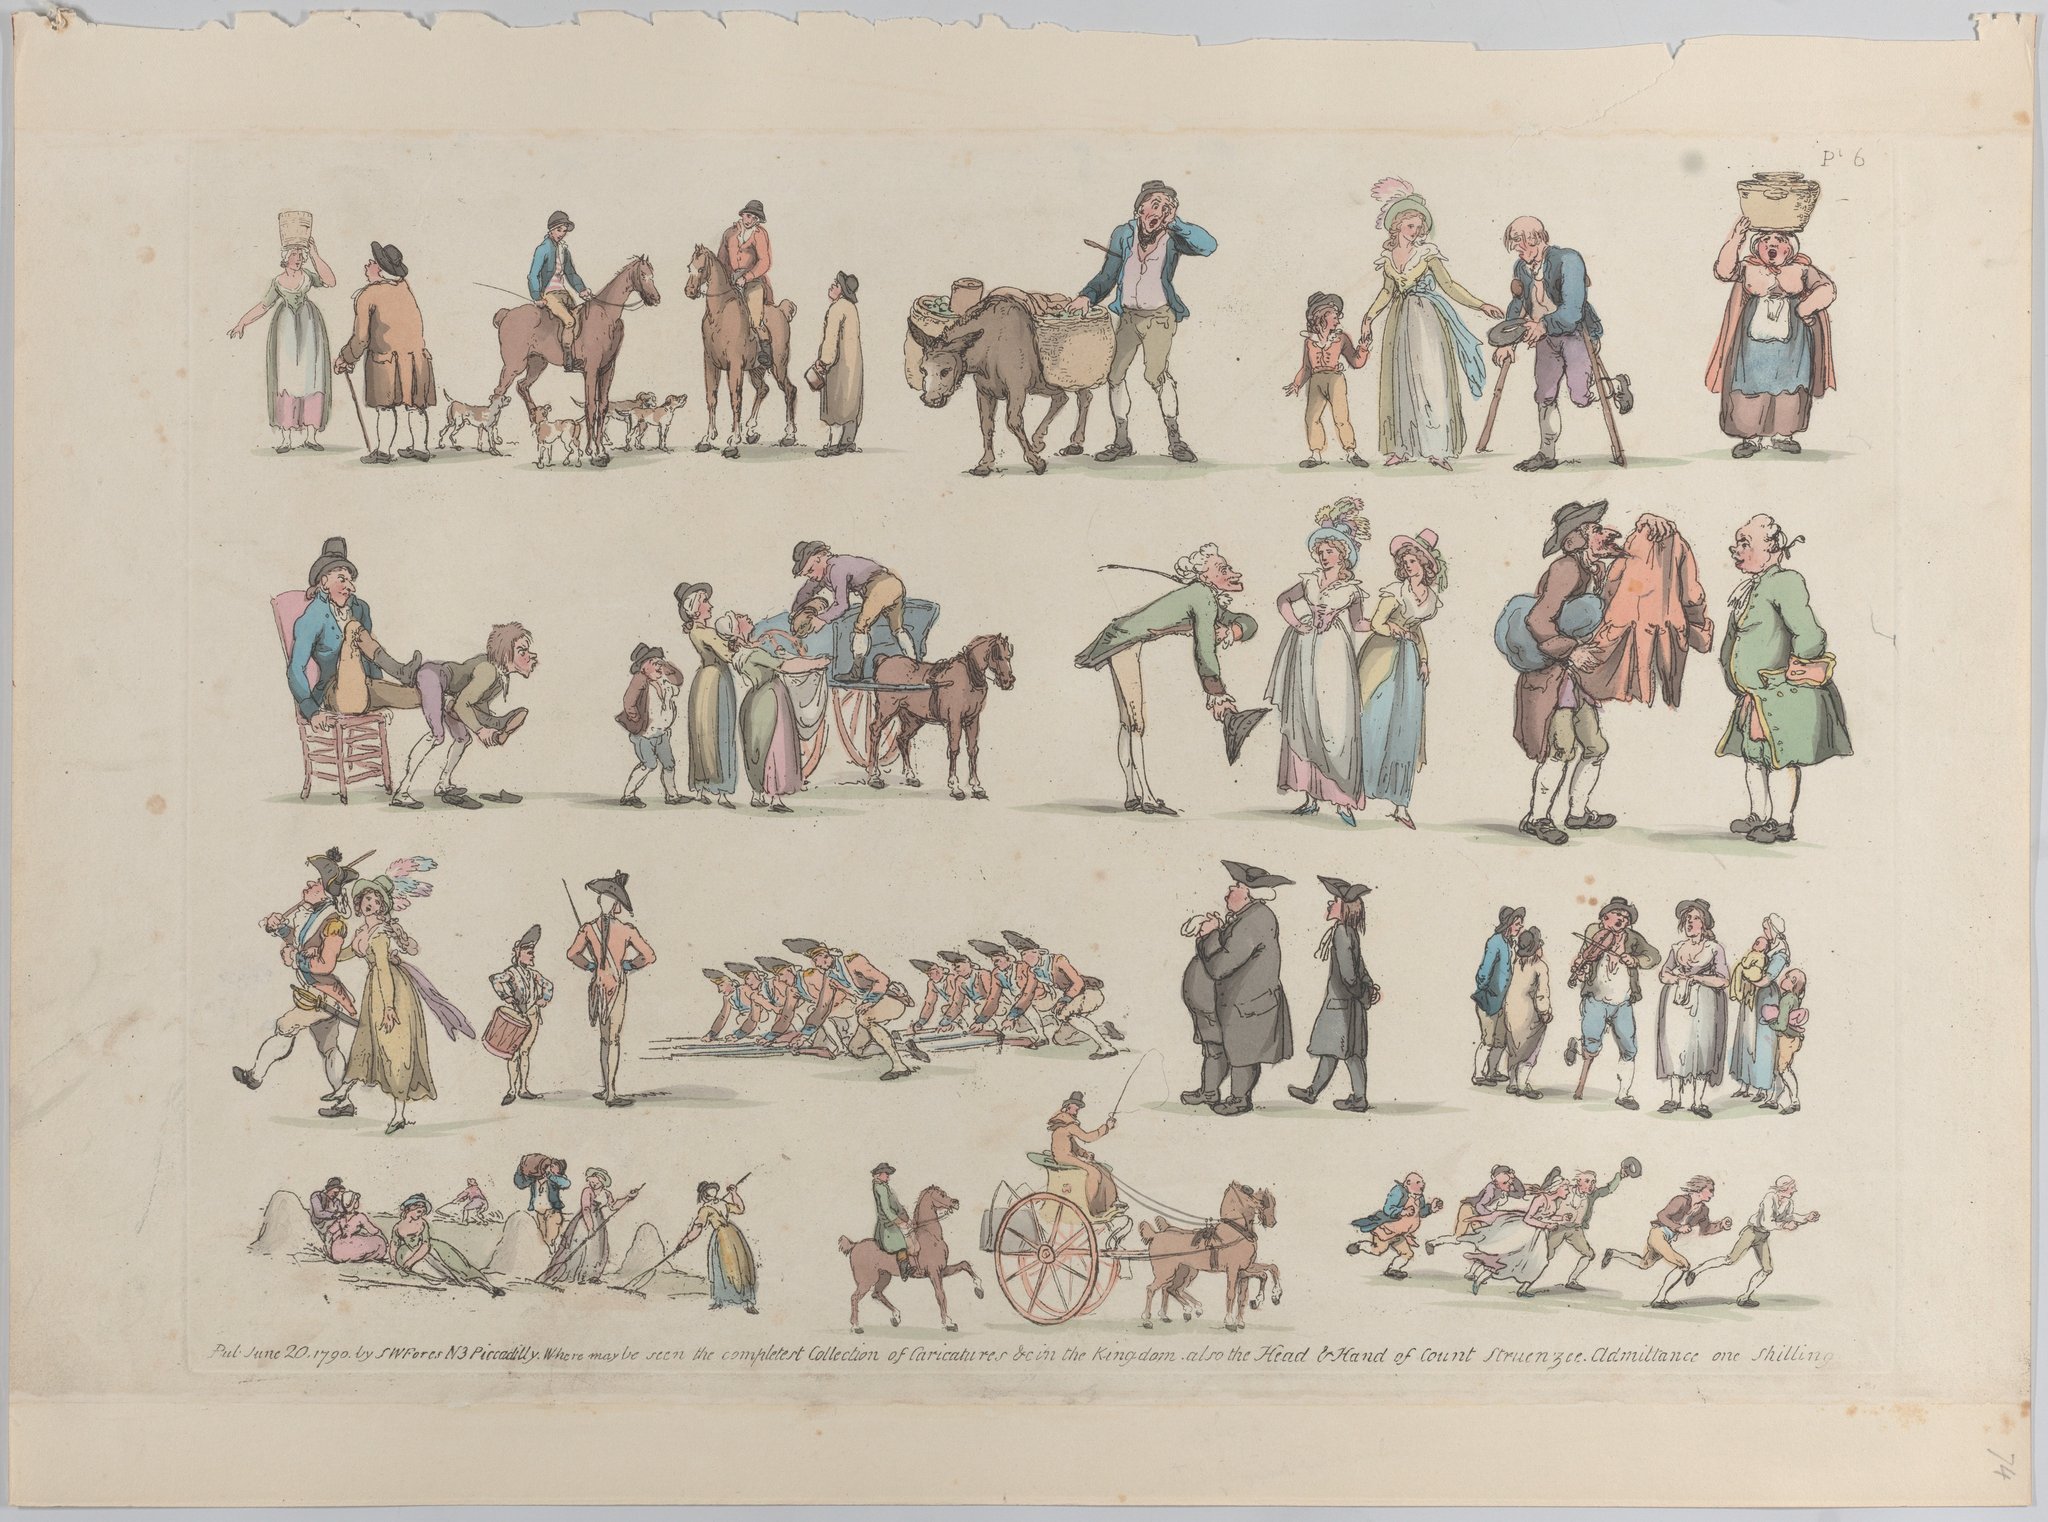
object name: print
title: Plate 6, Outlines of Figures, Landscapes and Cattle...for the Use of Learners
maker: thomas rowlandson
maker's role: artist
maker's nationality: british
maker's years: 1757-1827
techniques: etching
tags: men,women,horses,caricature